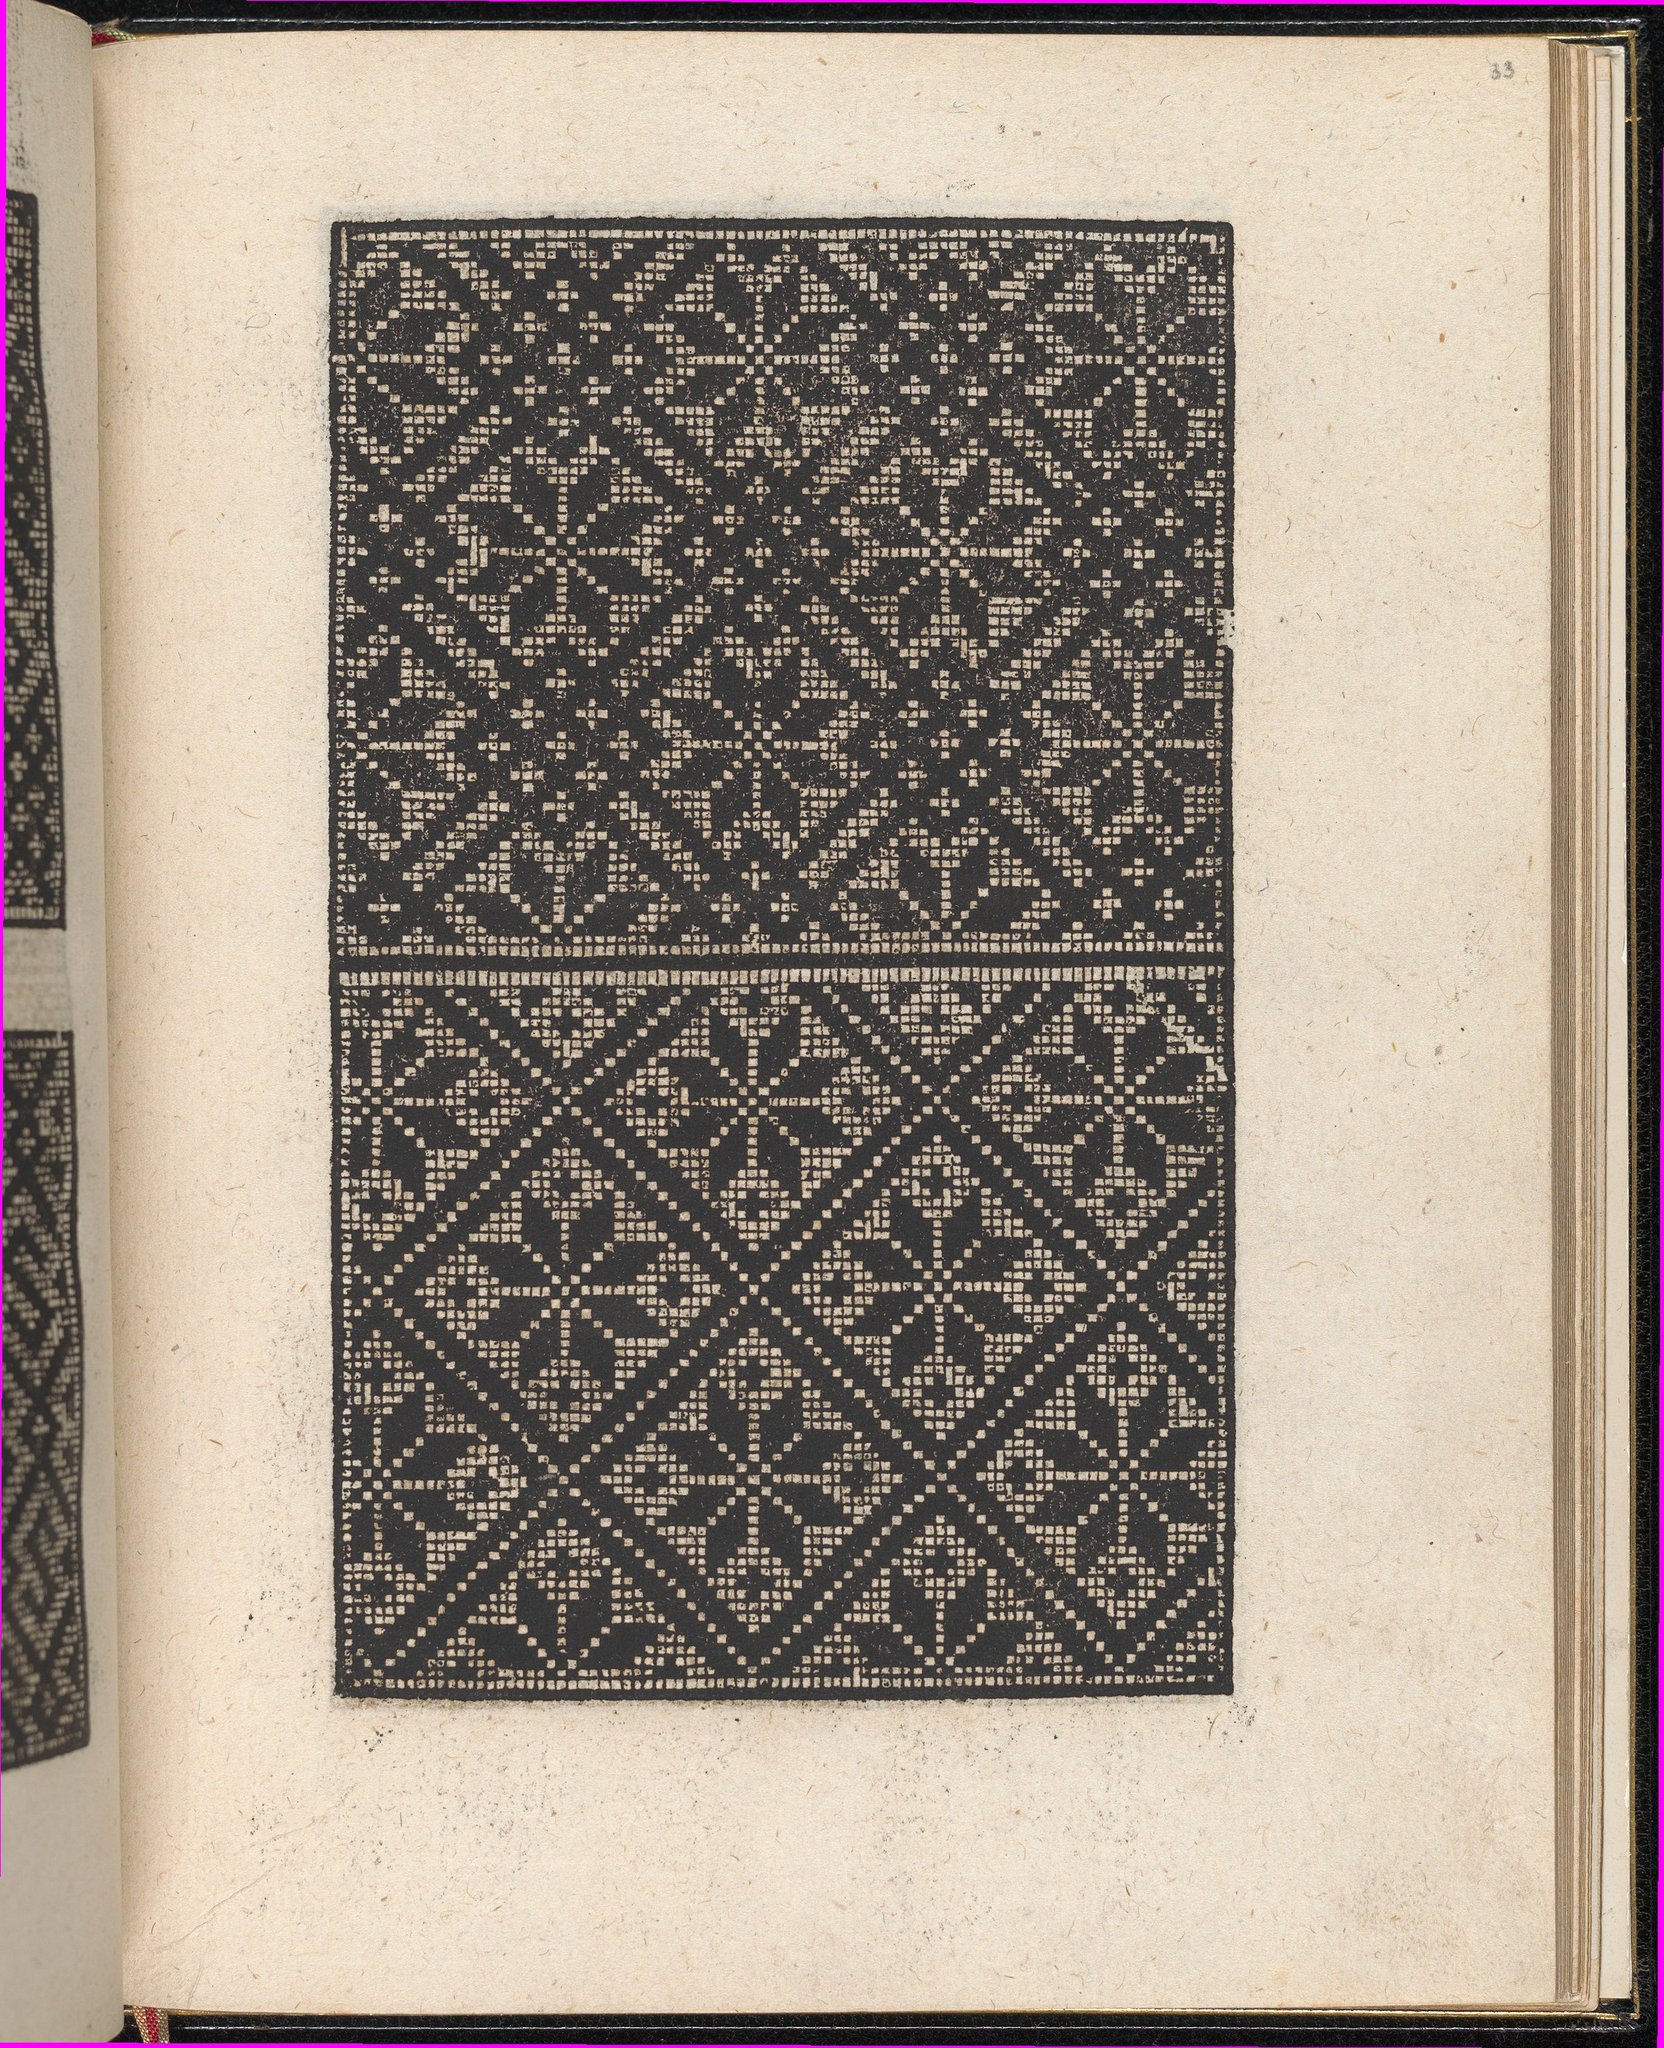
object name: book print ornament architecture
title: Page from Ein new kunstlich Modelbuch...(Page 33r)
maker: peter quentel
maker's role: publisher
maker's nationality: german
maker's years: 1500-1550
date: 1544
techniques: woodcut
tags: ornament